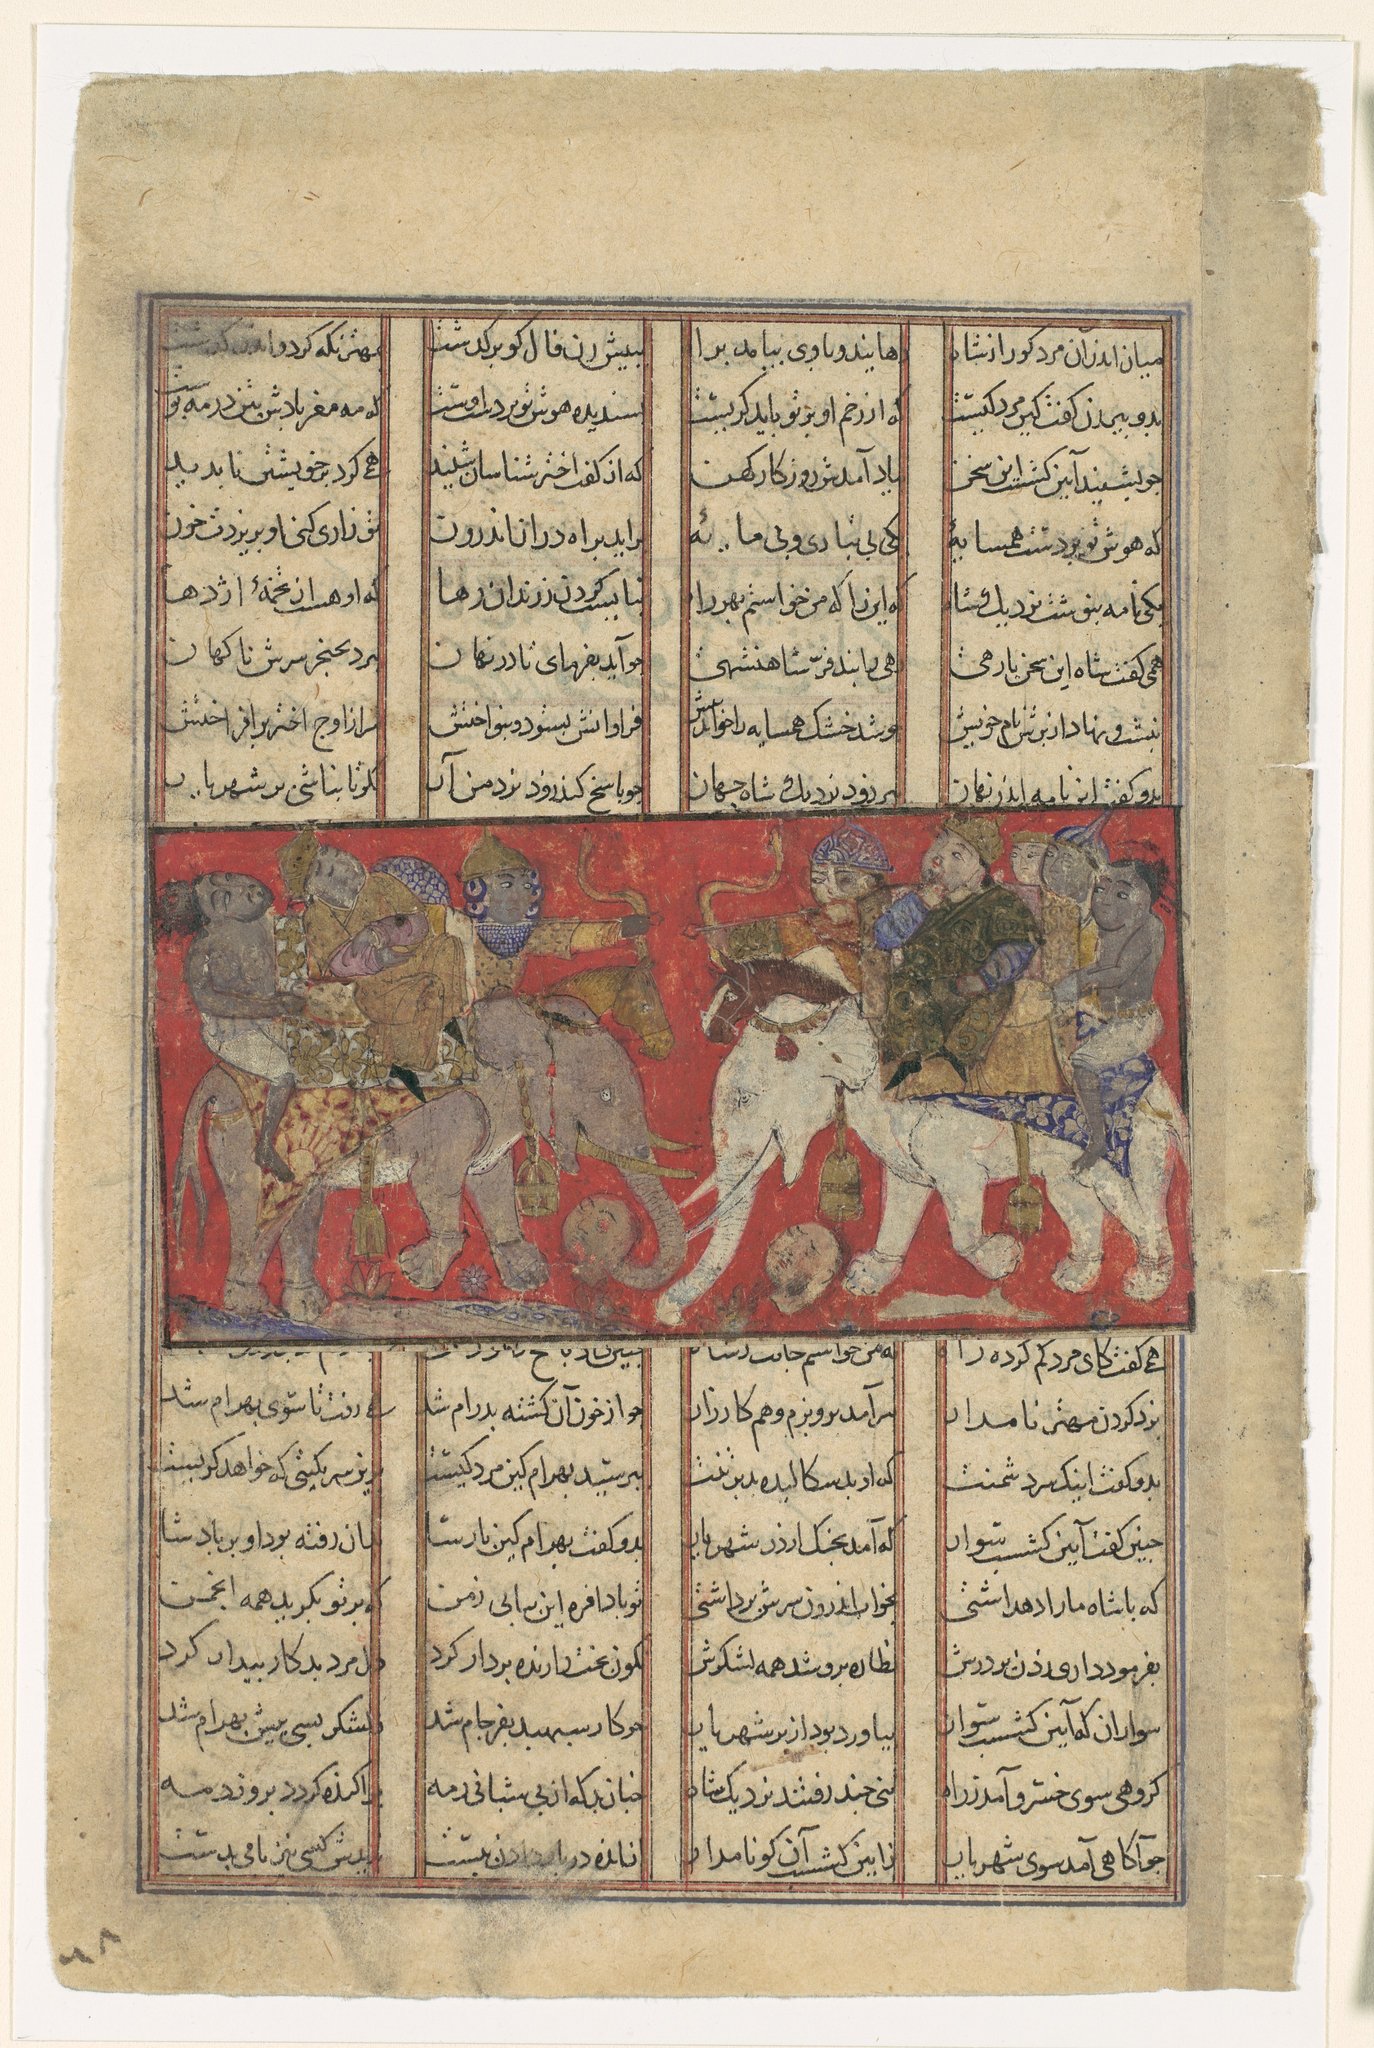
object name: folio from an illustrated manuscript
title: "The First Combat of Gav and Talhand", Folio from a Shahnama (Book of Kings)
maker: abu'l qasim firdausi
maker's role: author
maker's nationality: iranian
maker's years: 935-1020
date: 1330-1340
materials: gold, ink, paper, silver, watercolor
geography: iran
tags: men,elephants